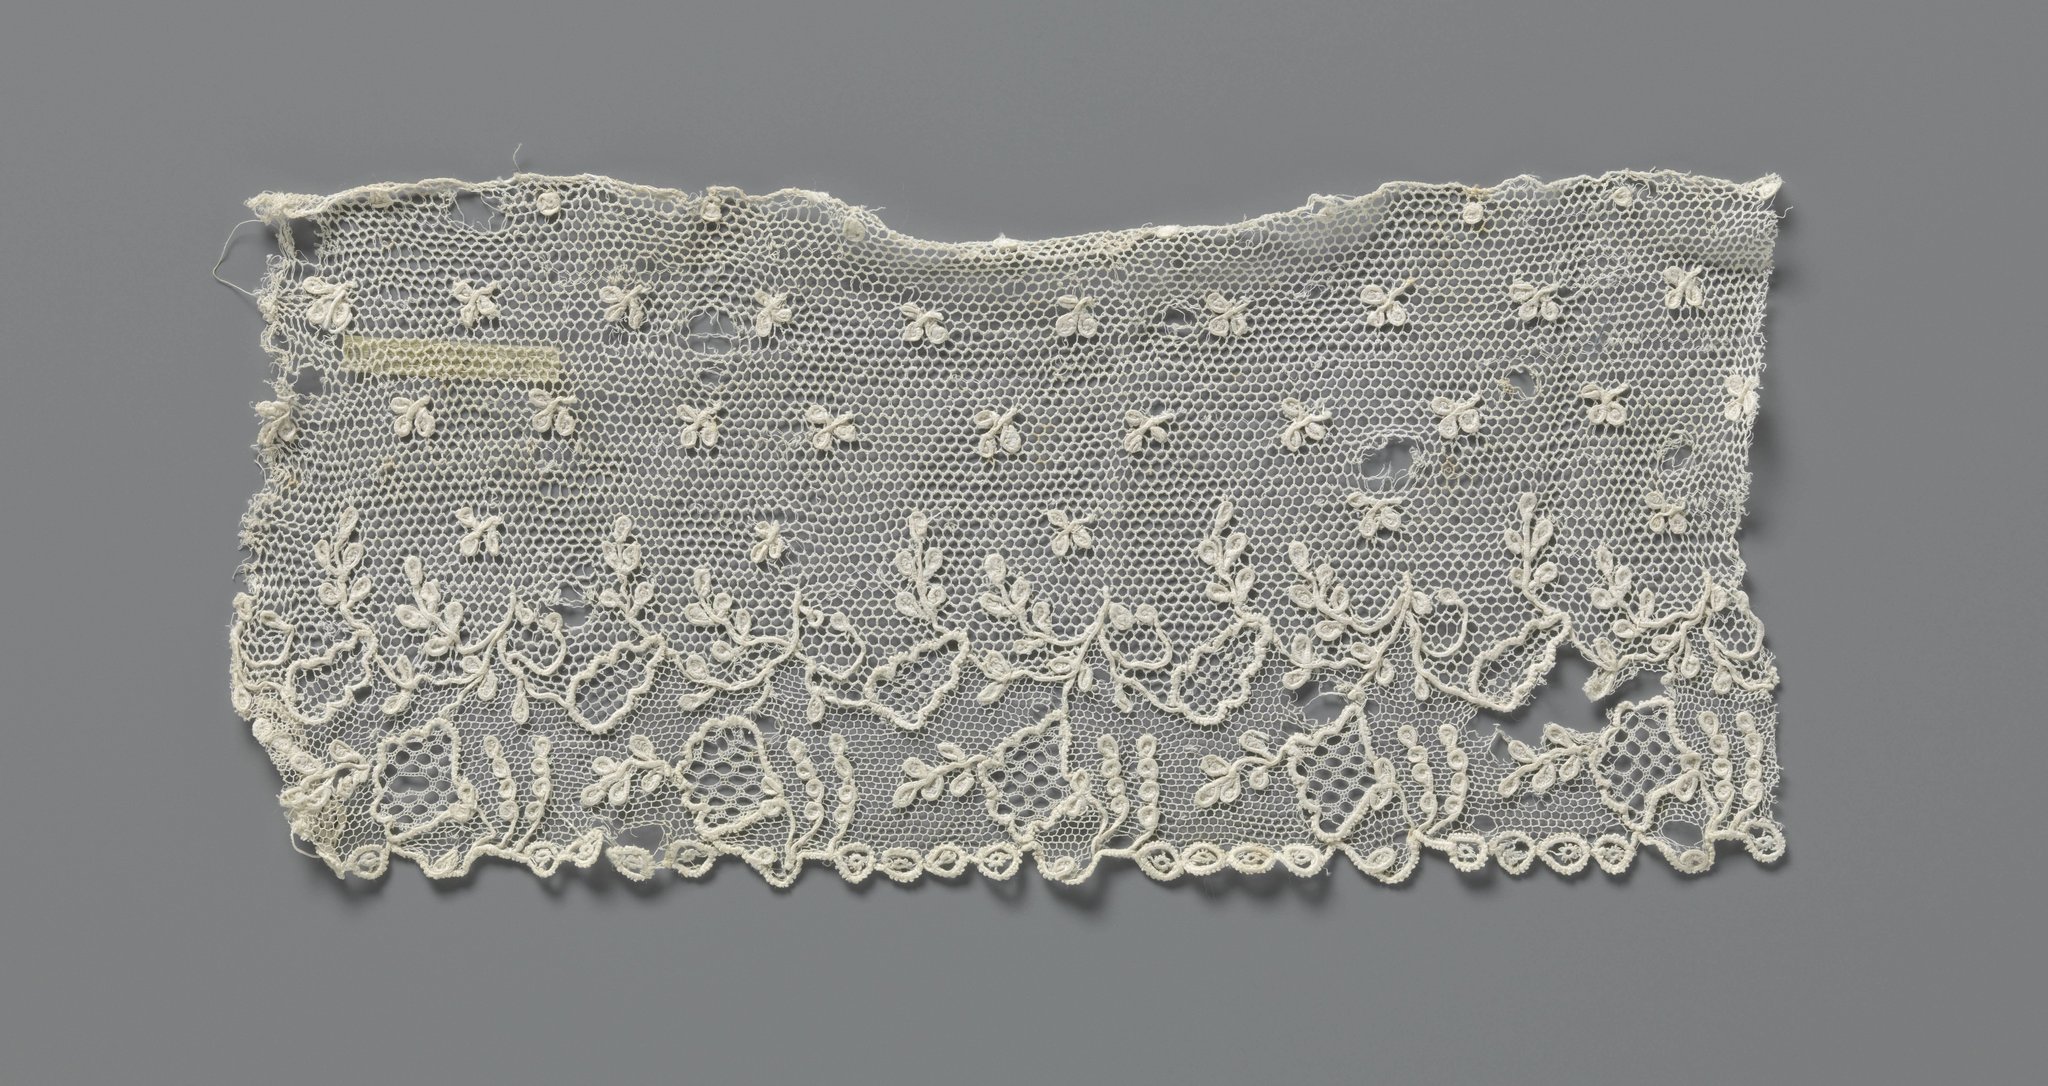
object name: strip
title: Strook naaldkant met klaverblaadjes en waaiervormige bloemen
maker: Anonymous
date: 1775-1799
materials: linen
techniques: lace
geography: alençon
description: Strook naturelkleurige naaldkant: heren-Alençon. Strooimotief met klaverblaadjes op een fijne zeshoekige maasgrond. Langs de bovenrand een rij moesjes. Het patroon aan de onderzijde van de strook bestaat uit een aaneenschakeling van bladertakken met pluimen. Daaronder waaiervormige bloemen die vanuit de onderrand ontspringen, gevuld met een siergrond. De onderzijde is afgewerkt met geschulpte rand van gepicoteerde cirkeltjes met daarin een raderpicot. De bovenzijde is afgewerkt met een rechte rand.